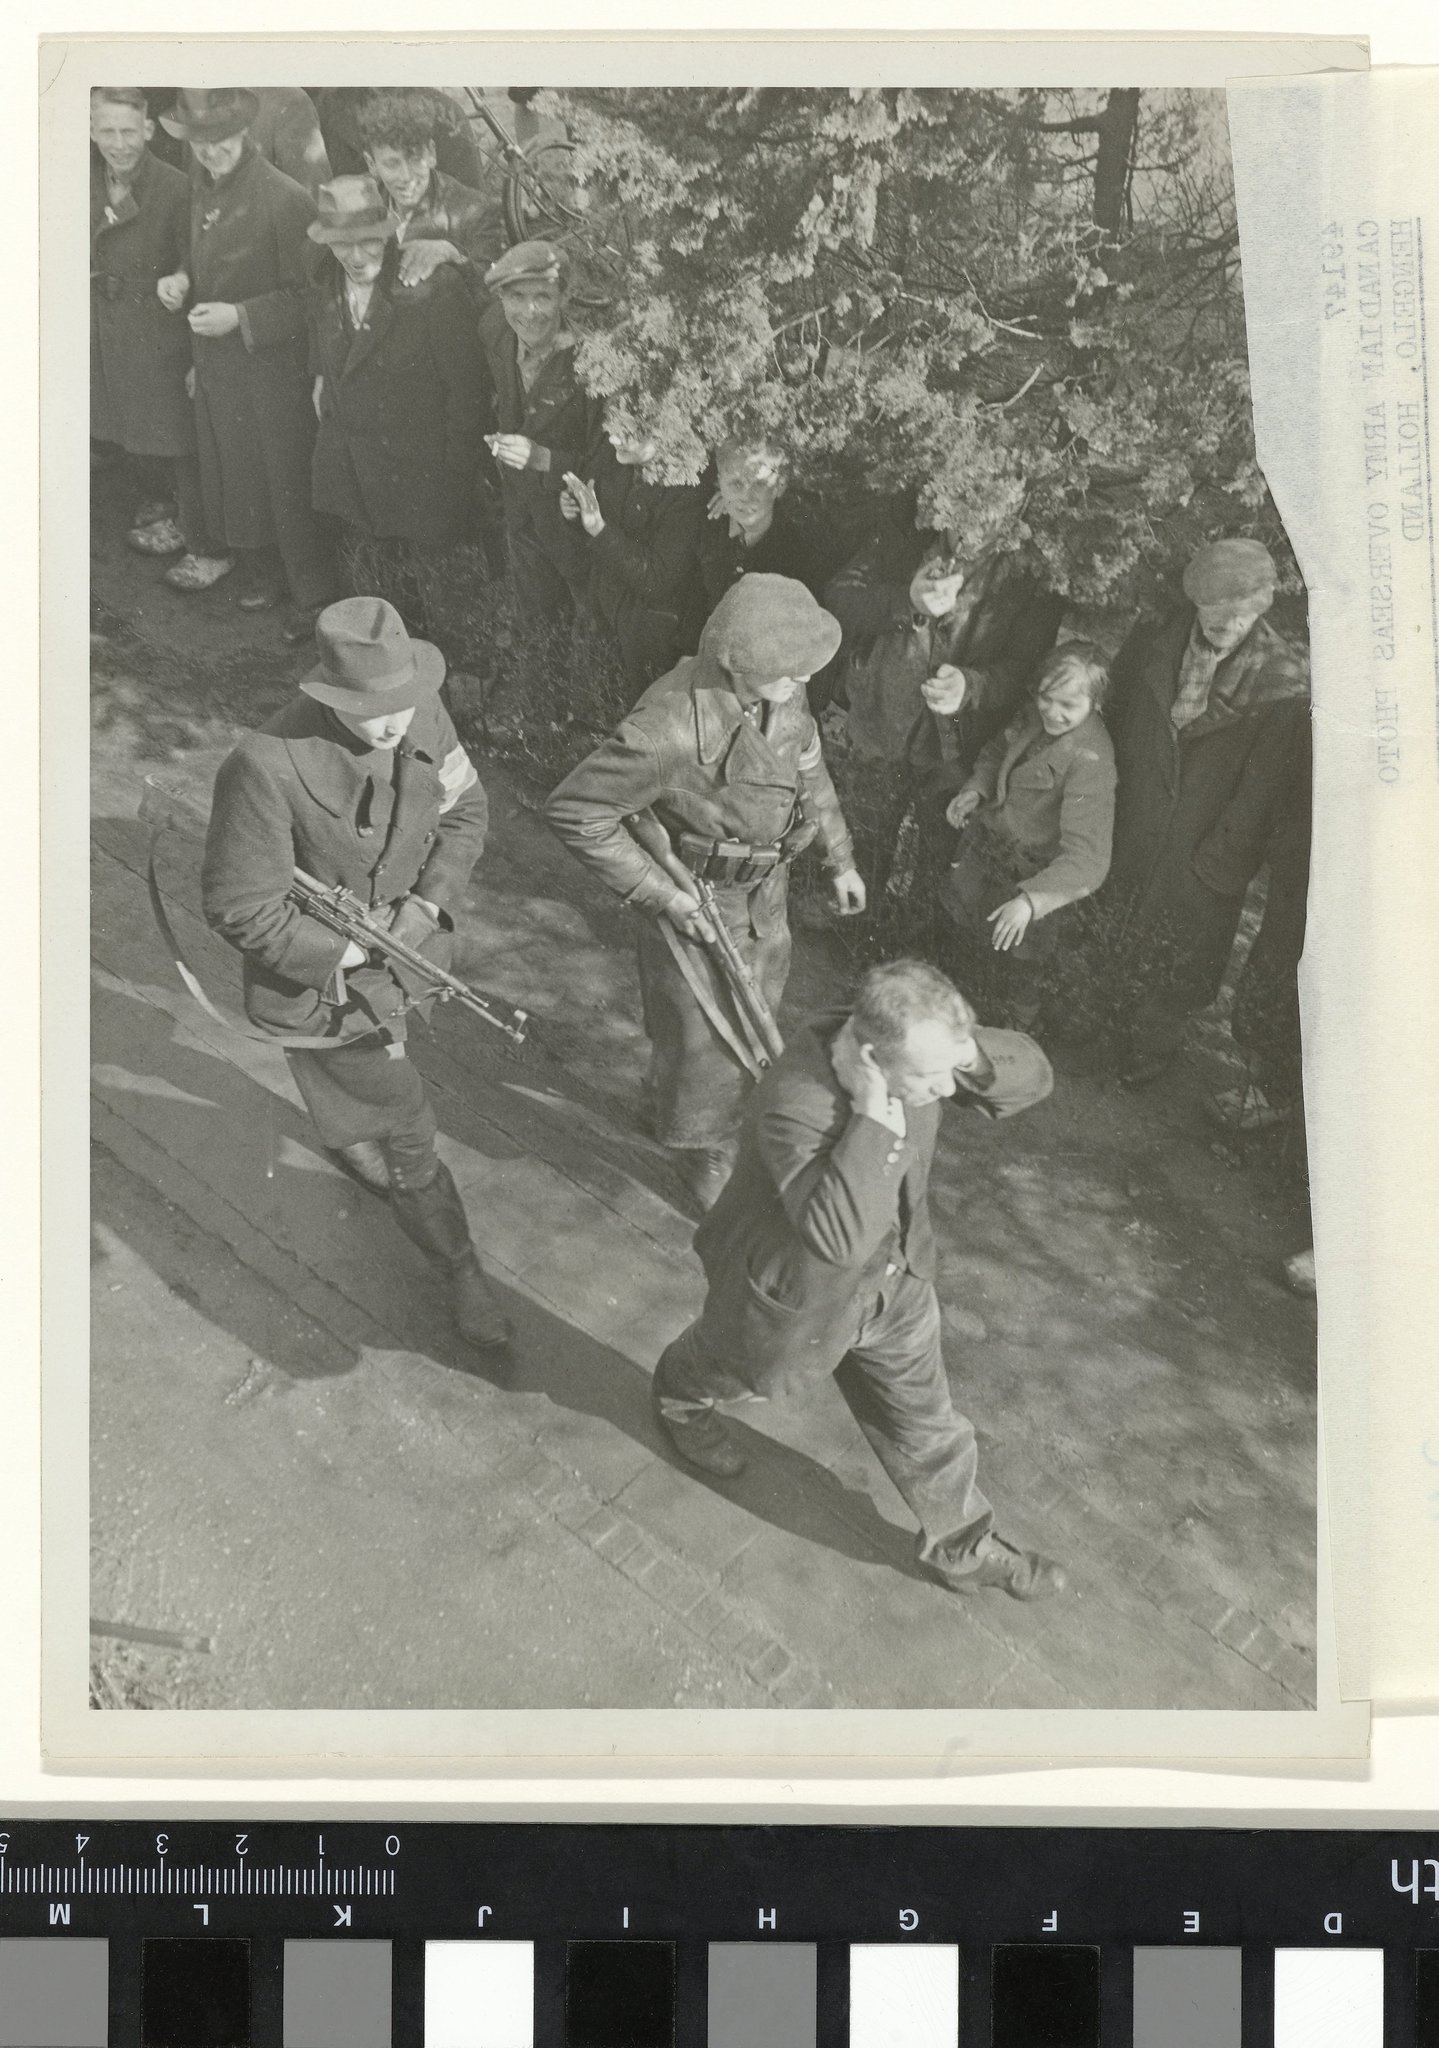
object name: documentary photograph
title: Een Nederlandse collaborateur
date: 1904-1945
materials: photographic support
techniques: photography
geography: hengelo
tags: publisher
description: Nederlanders hebben een collaborateur opgepakt.Op weg naar het huis van een leider van het verzet wordt hij aan de bevolking getoond, die enthousiast applaudiseerd.